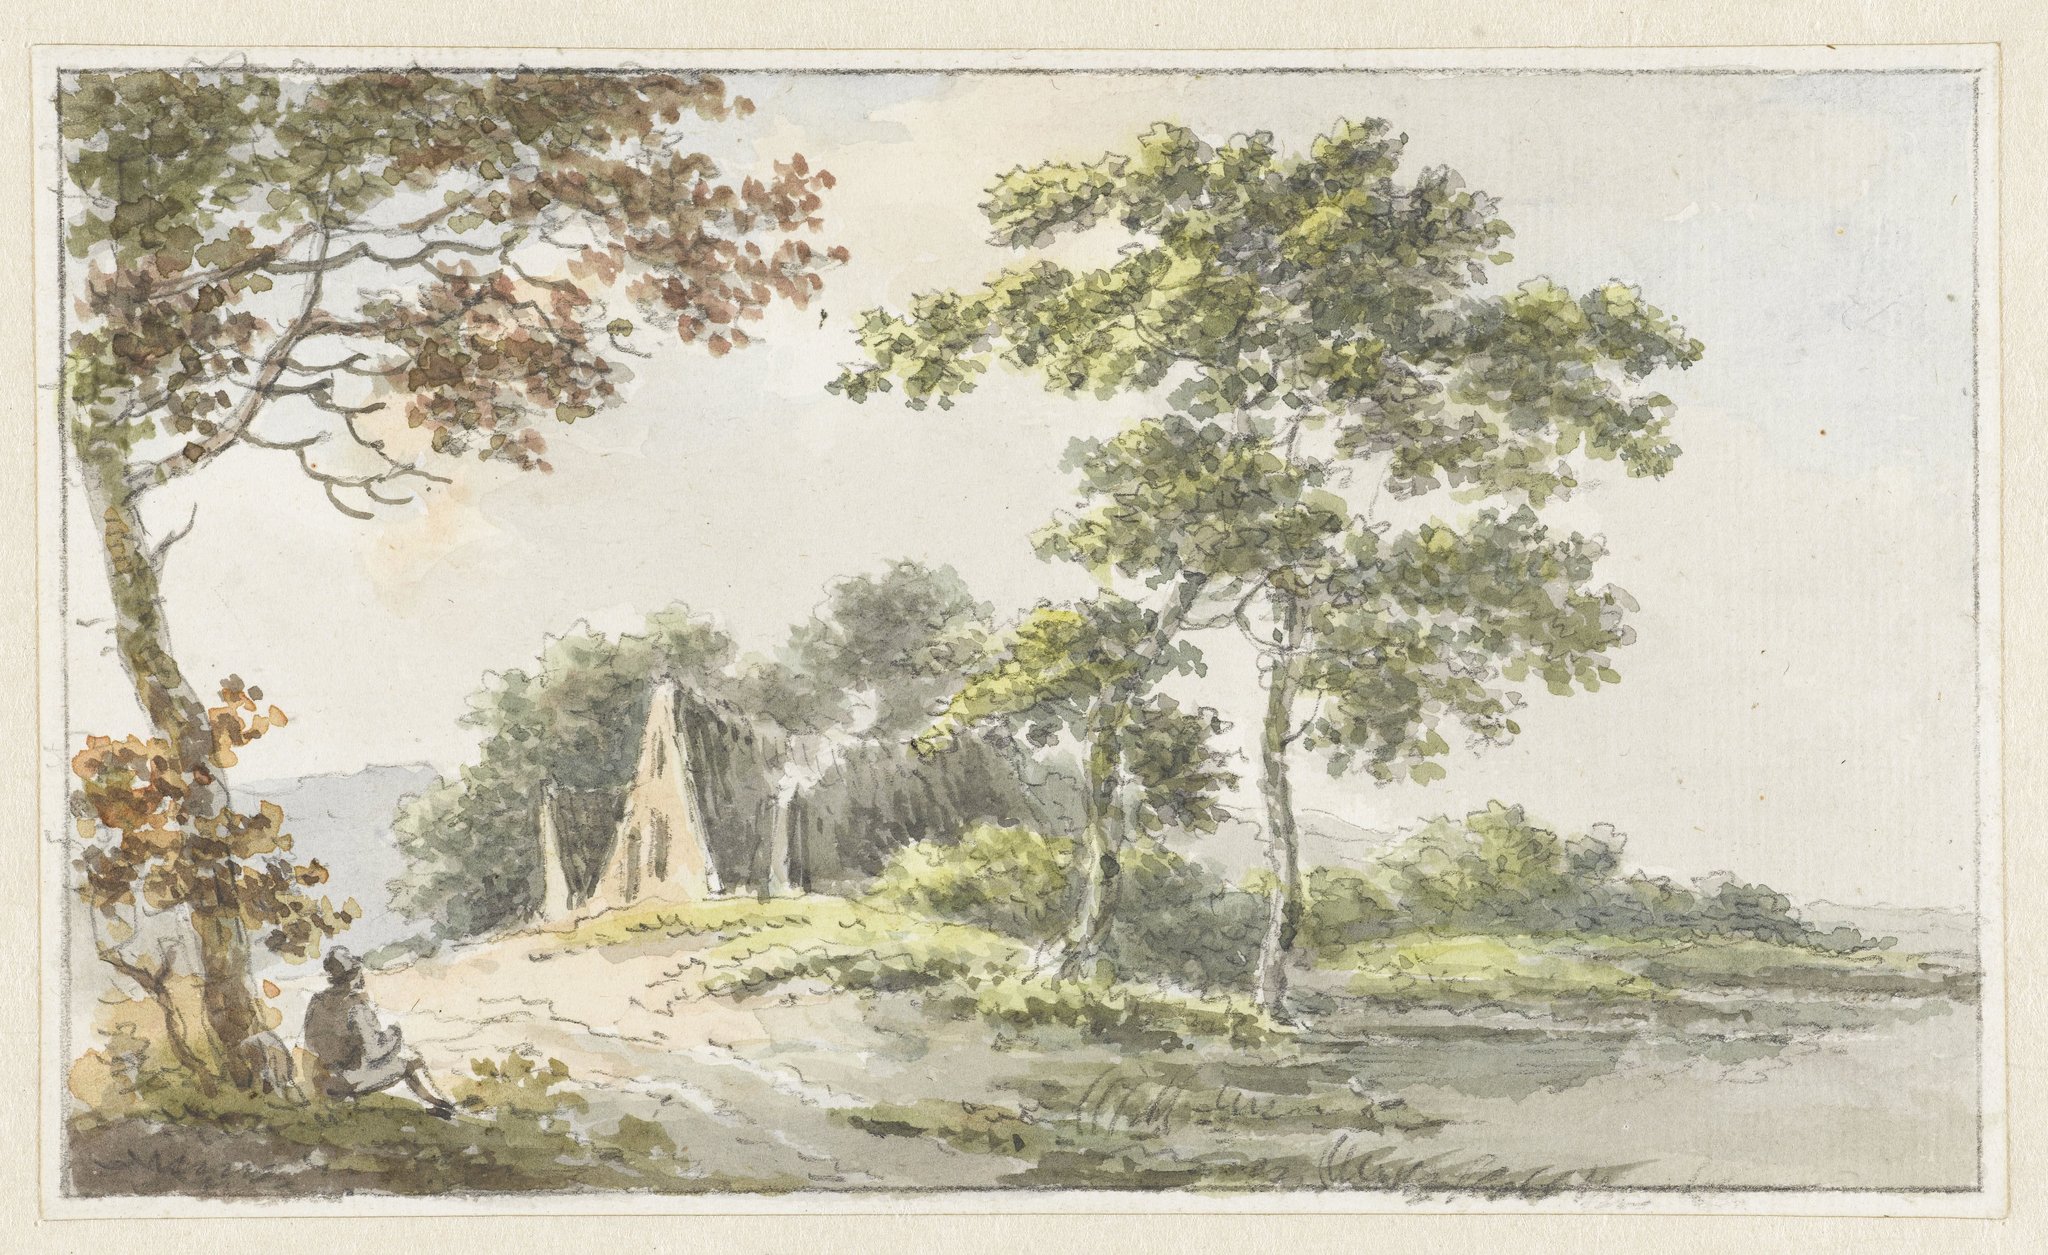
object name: drawing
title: Landschap met rustende wandelaar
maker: cecilia barbiers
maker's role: draughtsman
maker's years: 1809-1850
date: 1700-1800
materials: graphite, paper, watercolor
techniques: brush